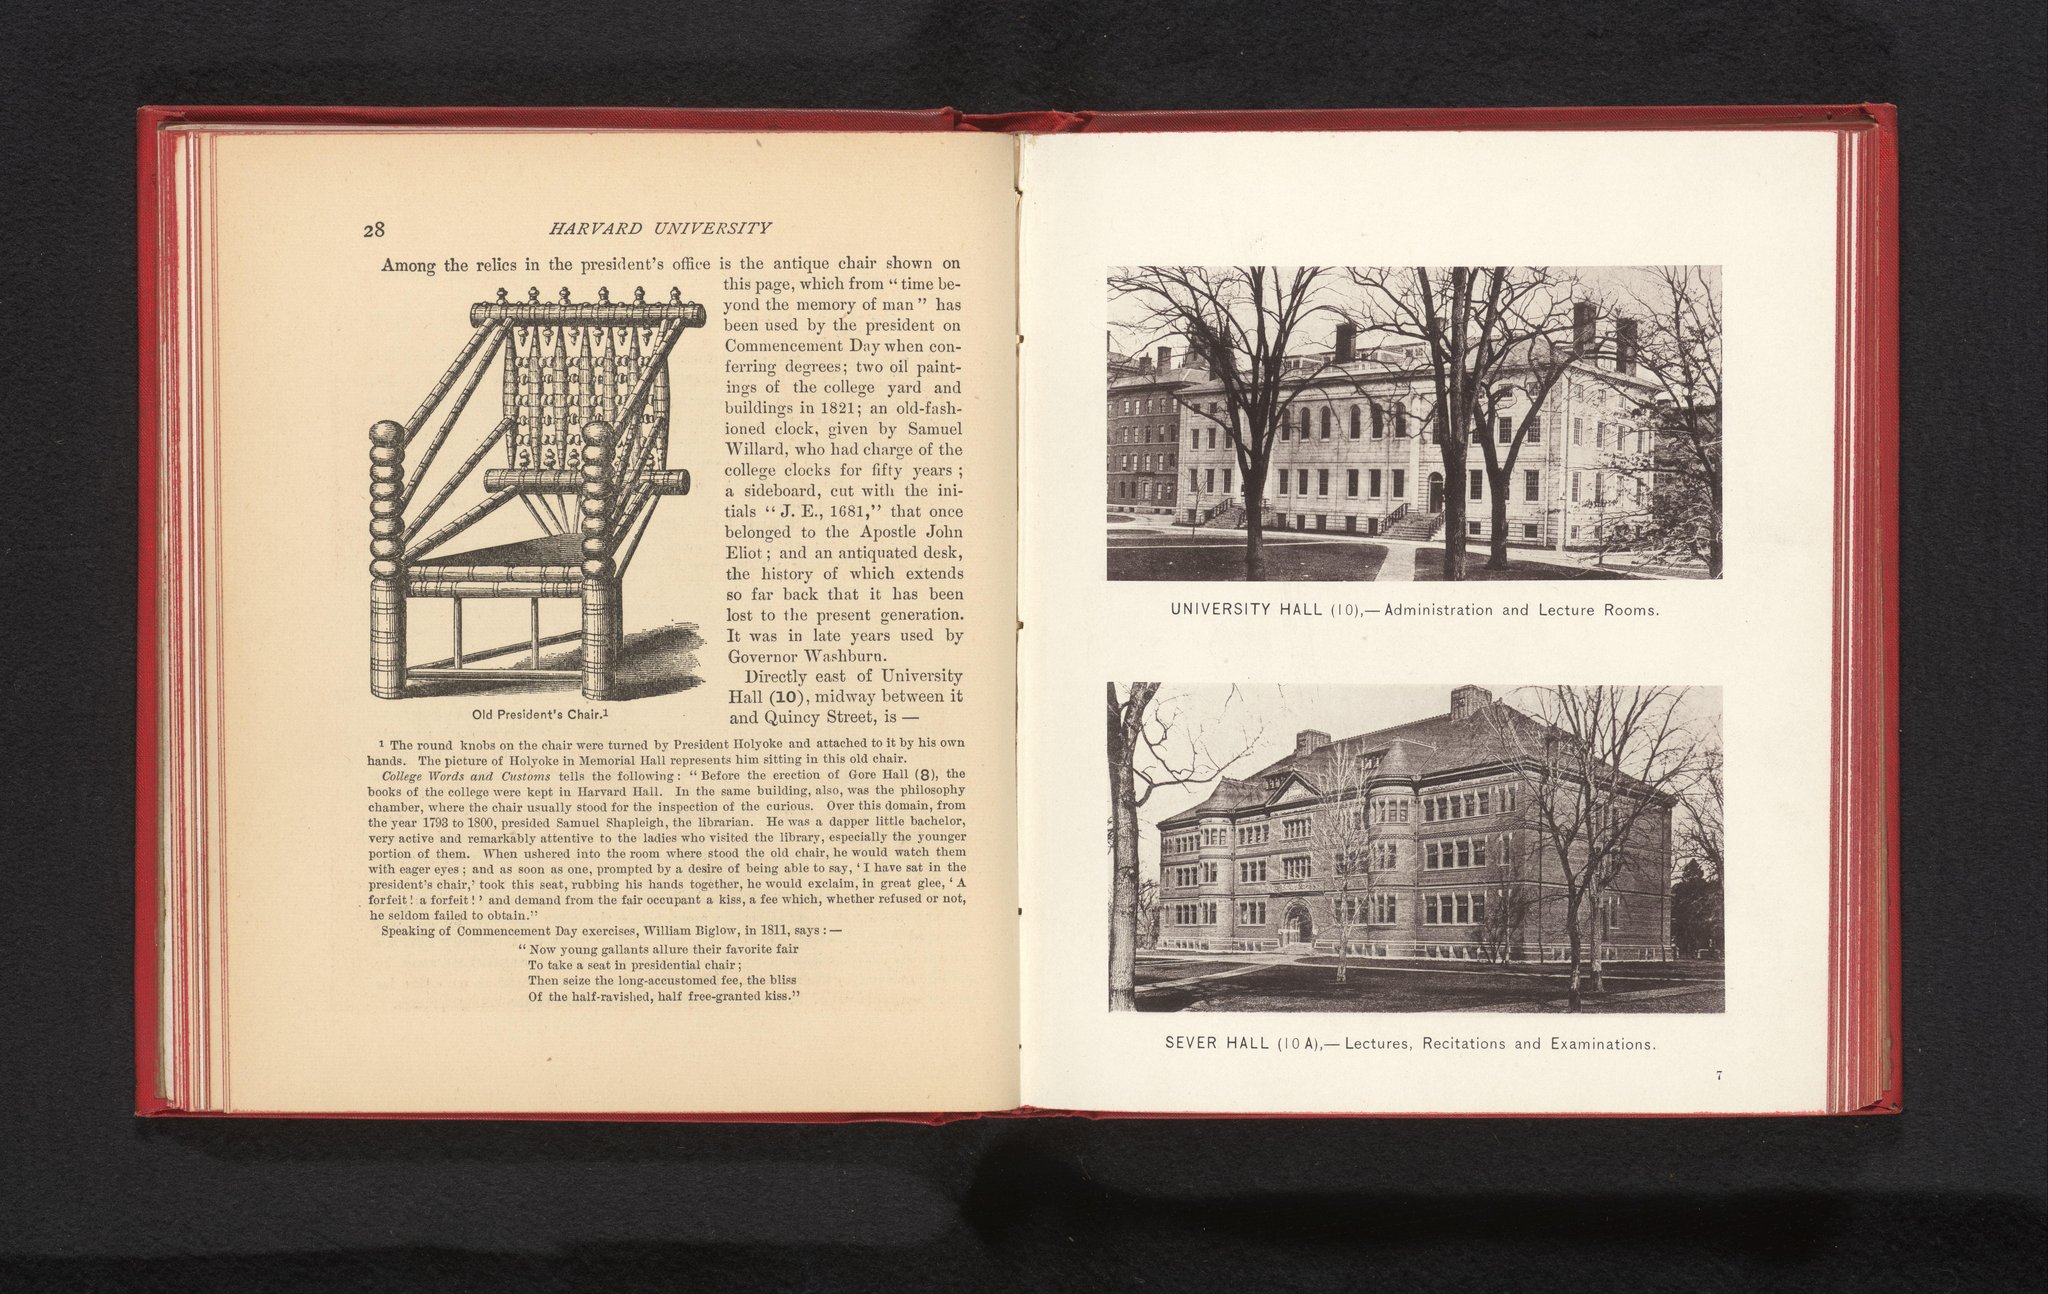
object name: photomechanical print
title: Sever Hall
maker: Anonymous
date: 1881-1886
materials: paper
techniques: photograph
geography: cambridge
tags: university building, college, façade (of house or building)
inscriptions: number: ‘(10) (10 A)’